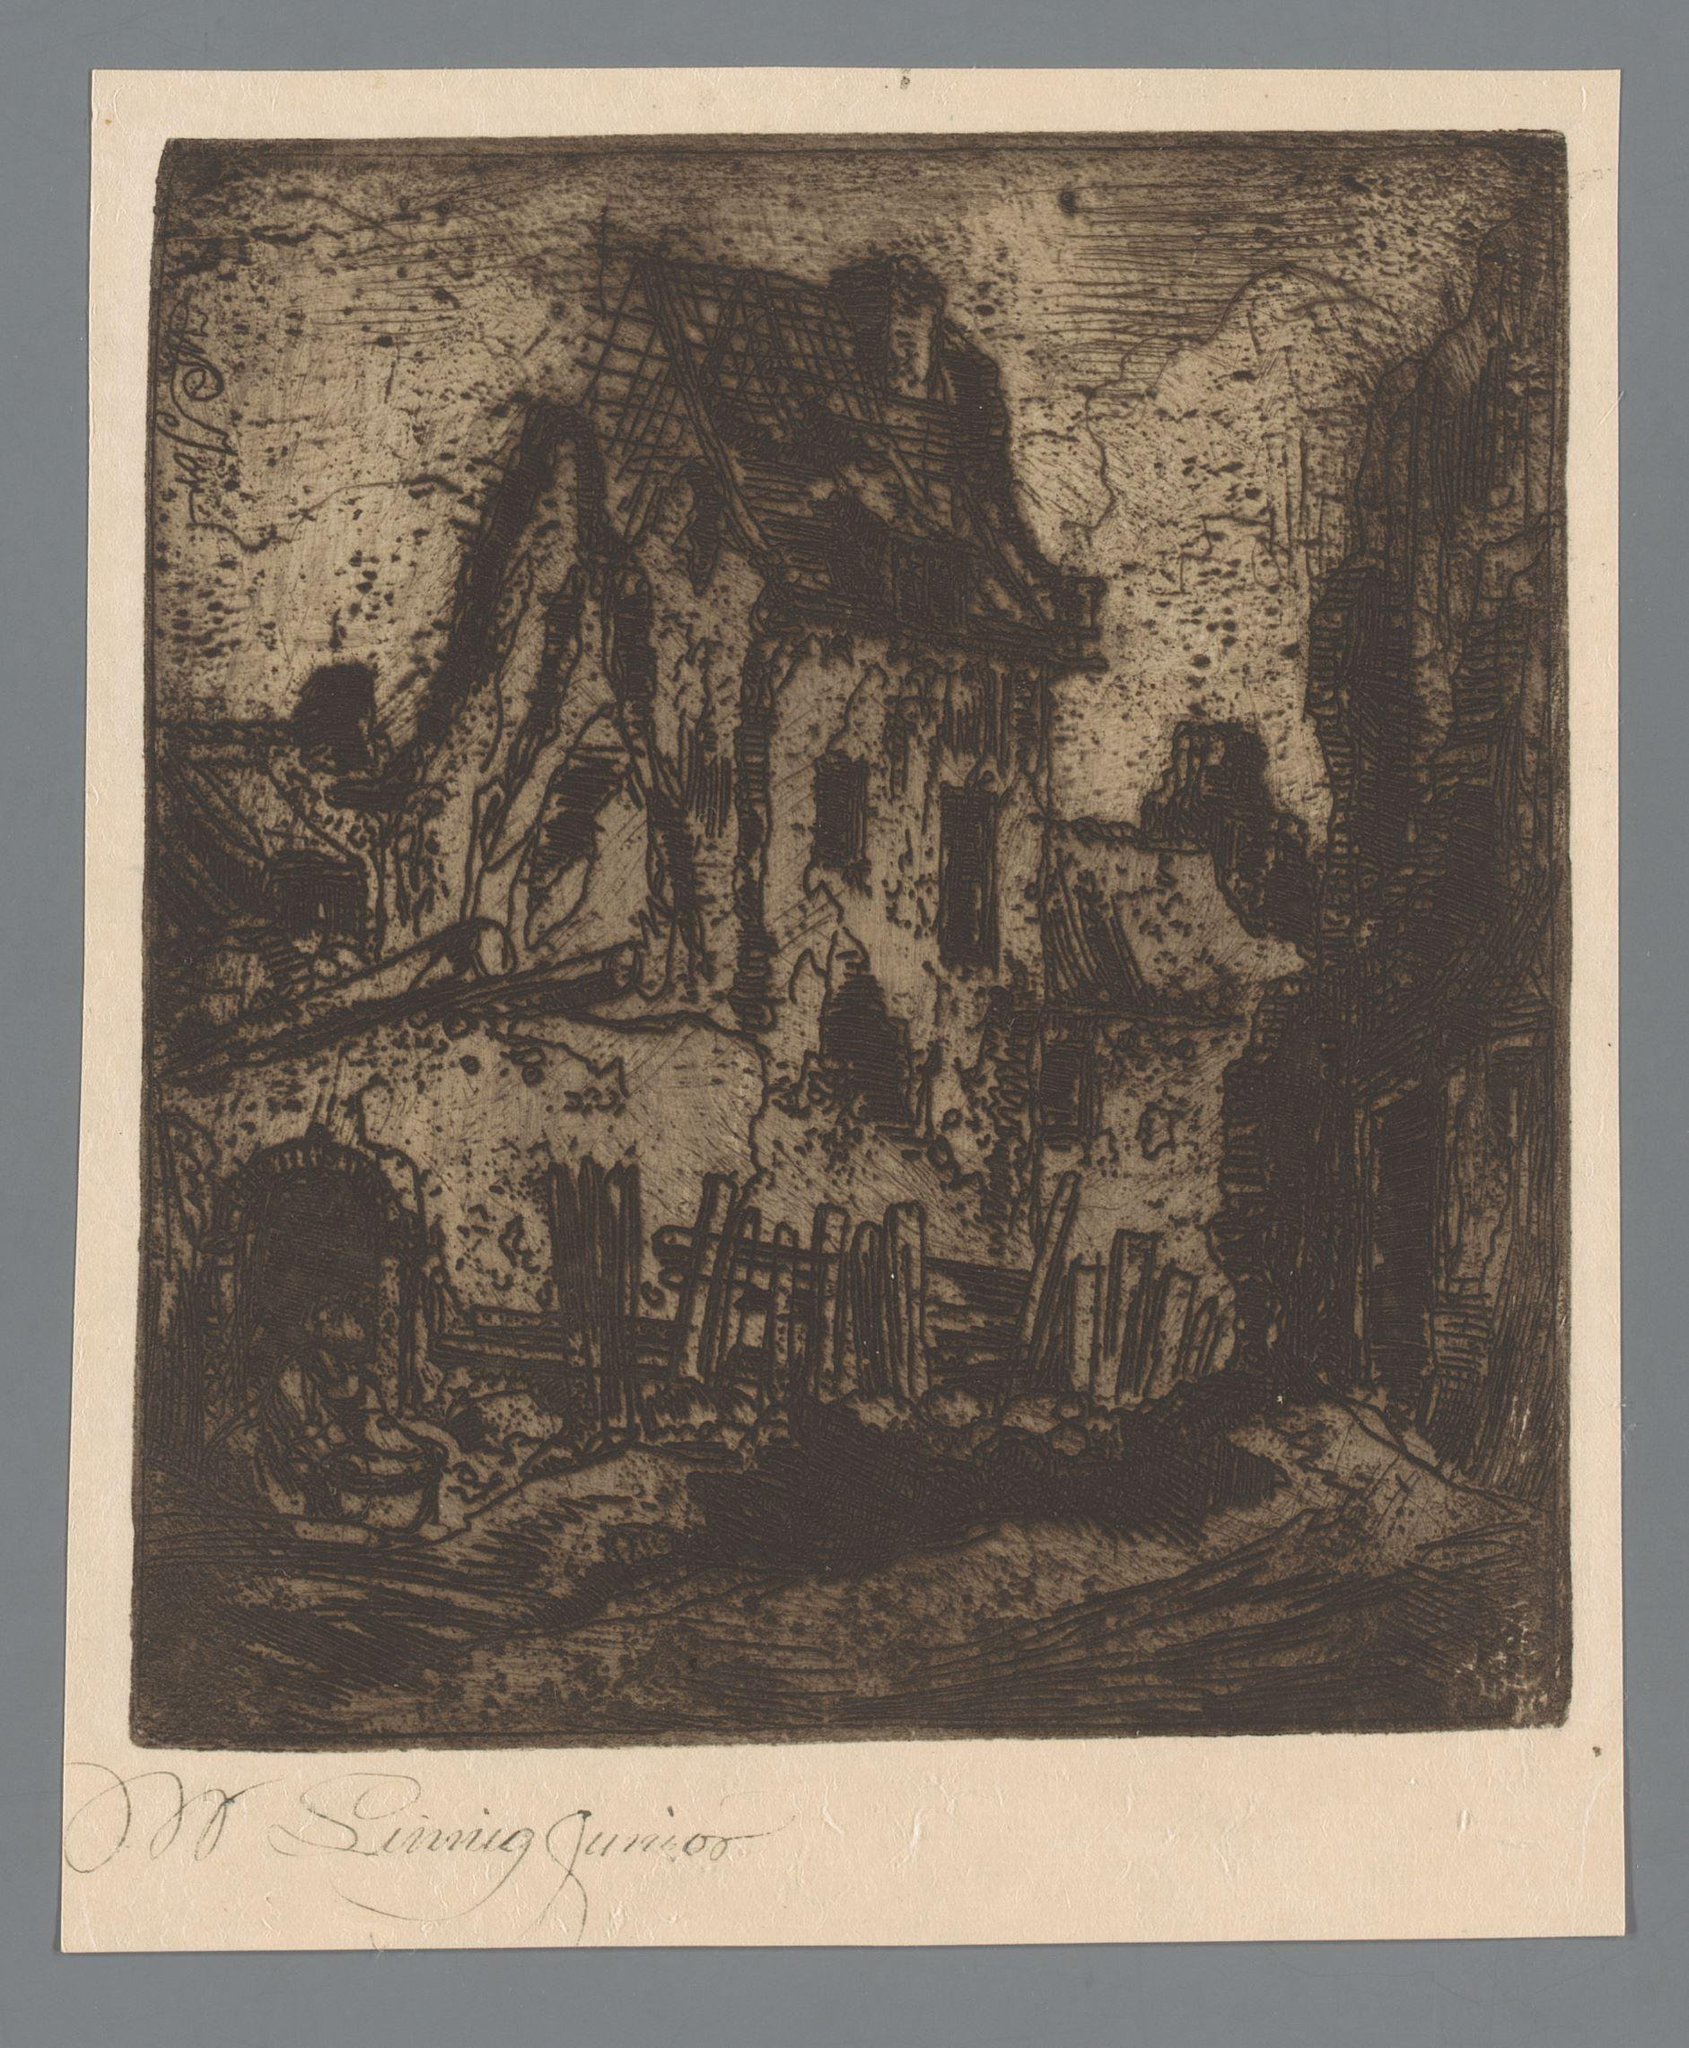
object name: print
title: Gezicht op de ruïne van een gebouw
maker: willem linnig (ii)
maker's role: print maker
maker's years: 1842-1890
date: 1852-1890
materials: paper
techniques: drypoint, etching, intaglio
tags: ruin of a dwelling, house, castle, etc.